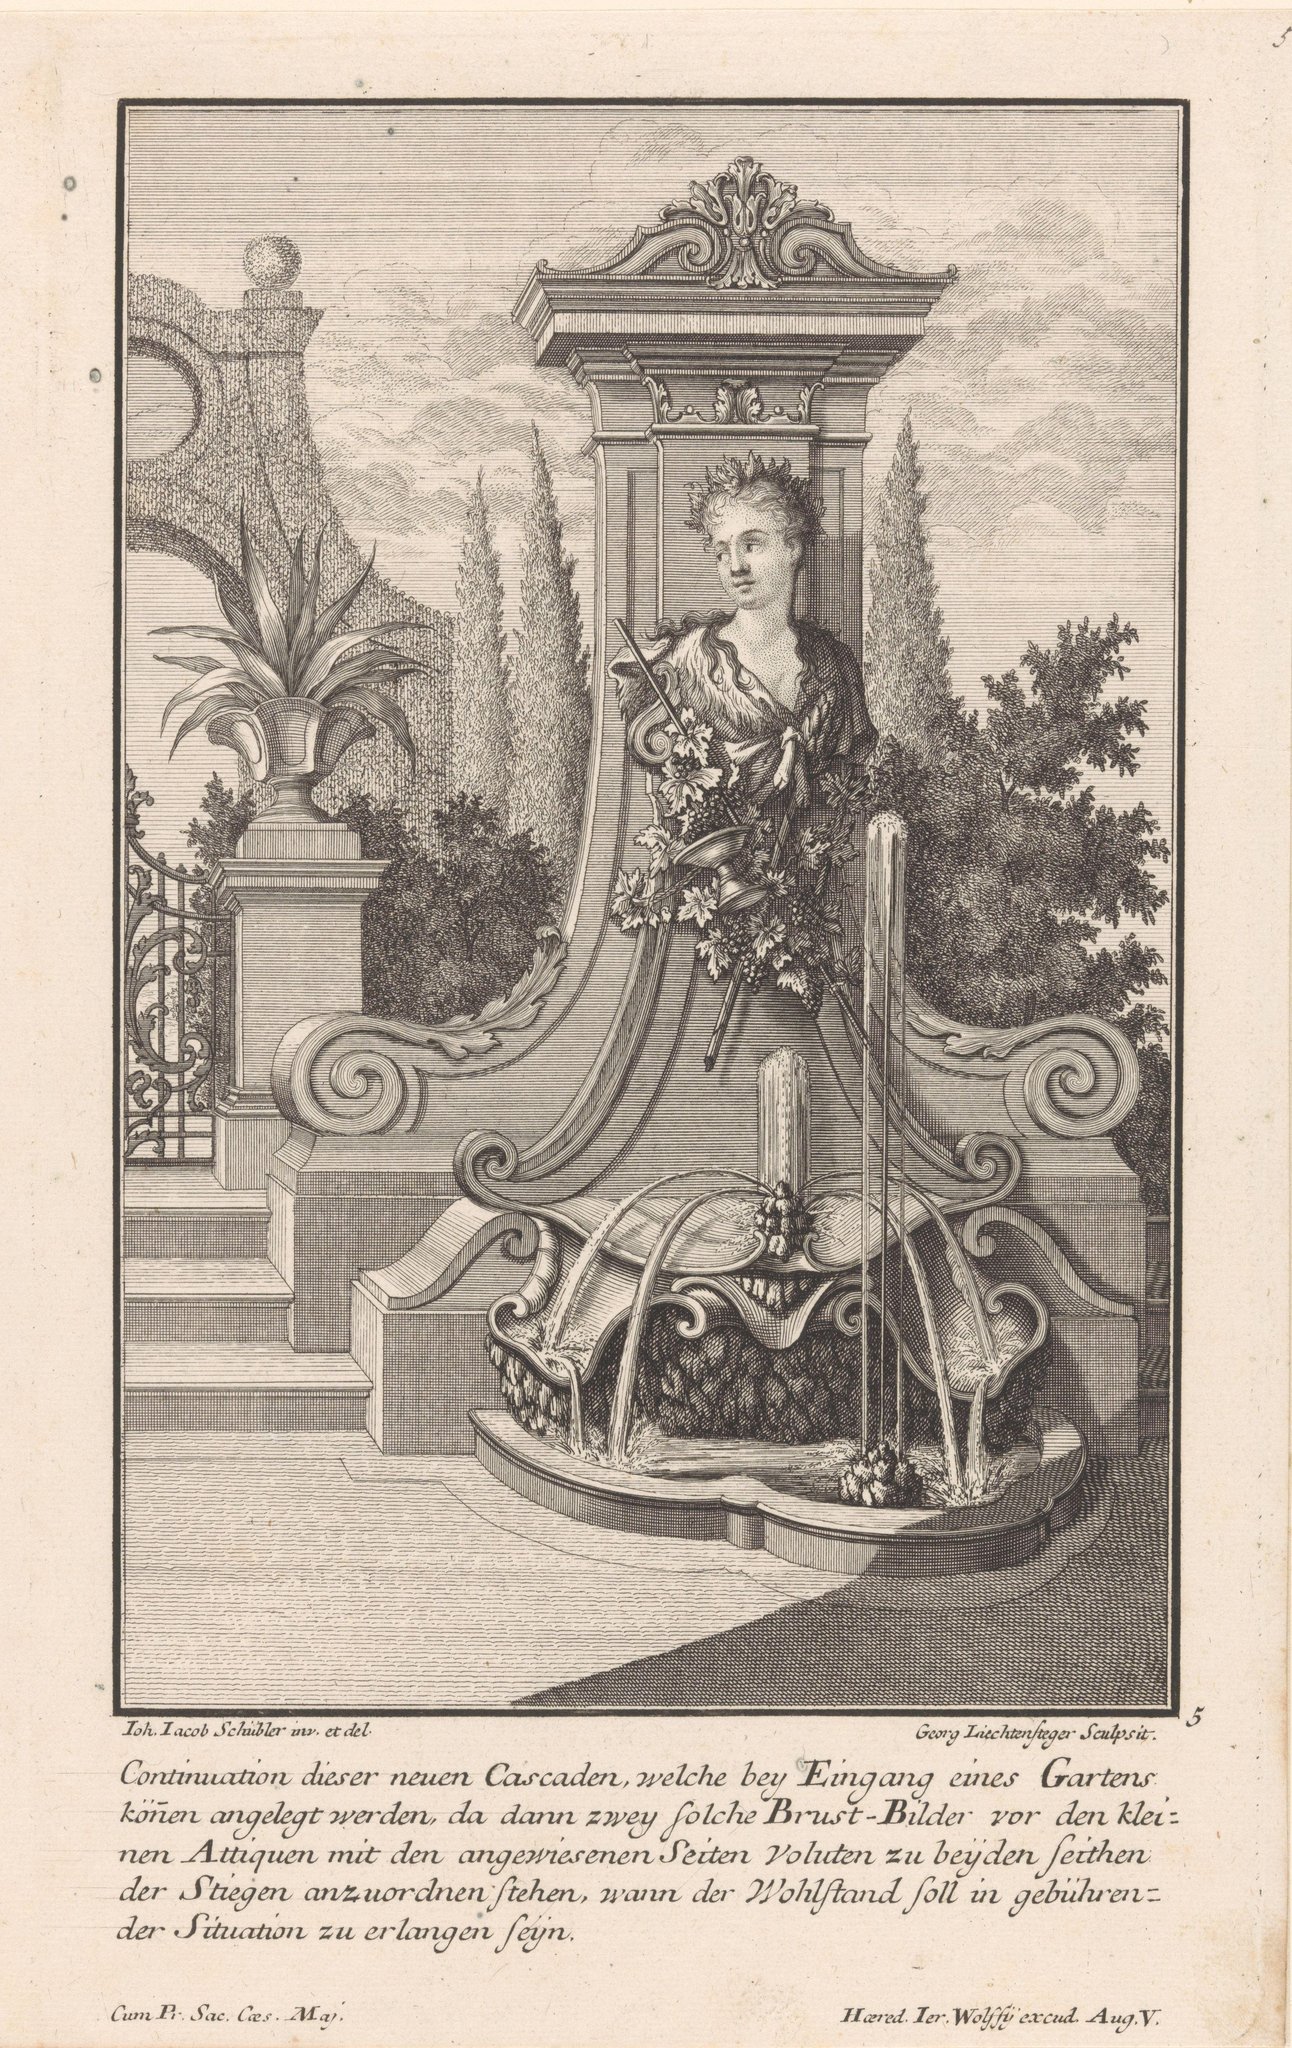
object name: ornament print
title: Johann Jacob Schüblers Neunzehende Ausgabe seines vorhabenden Wercks, Worinnen vorgestellet werden Unterschiedliche Moderne Garten-Ornemens (...)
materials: paper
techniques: engraving, etching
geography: augsburg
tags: (story of) bacchus (dionysus), liber, garden fountain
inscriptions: collector's mark: Lugt 2228, collector's mark: Lugt 2760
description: In een landschap staat een geornamenteerde fontein met voluten en een buste van Bacchus met wijnranken en thyrsus. In de achtergrond ligt een tuin. In de ondermarge een vijfregelige Duitse tekst.